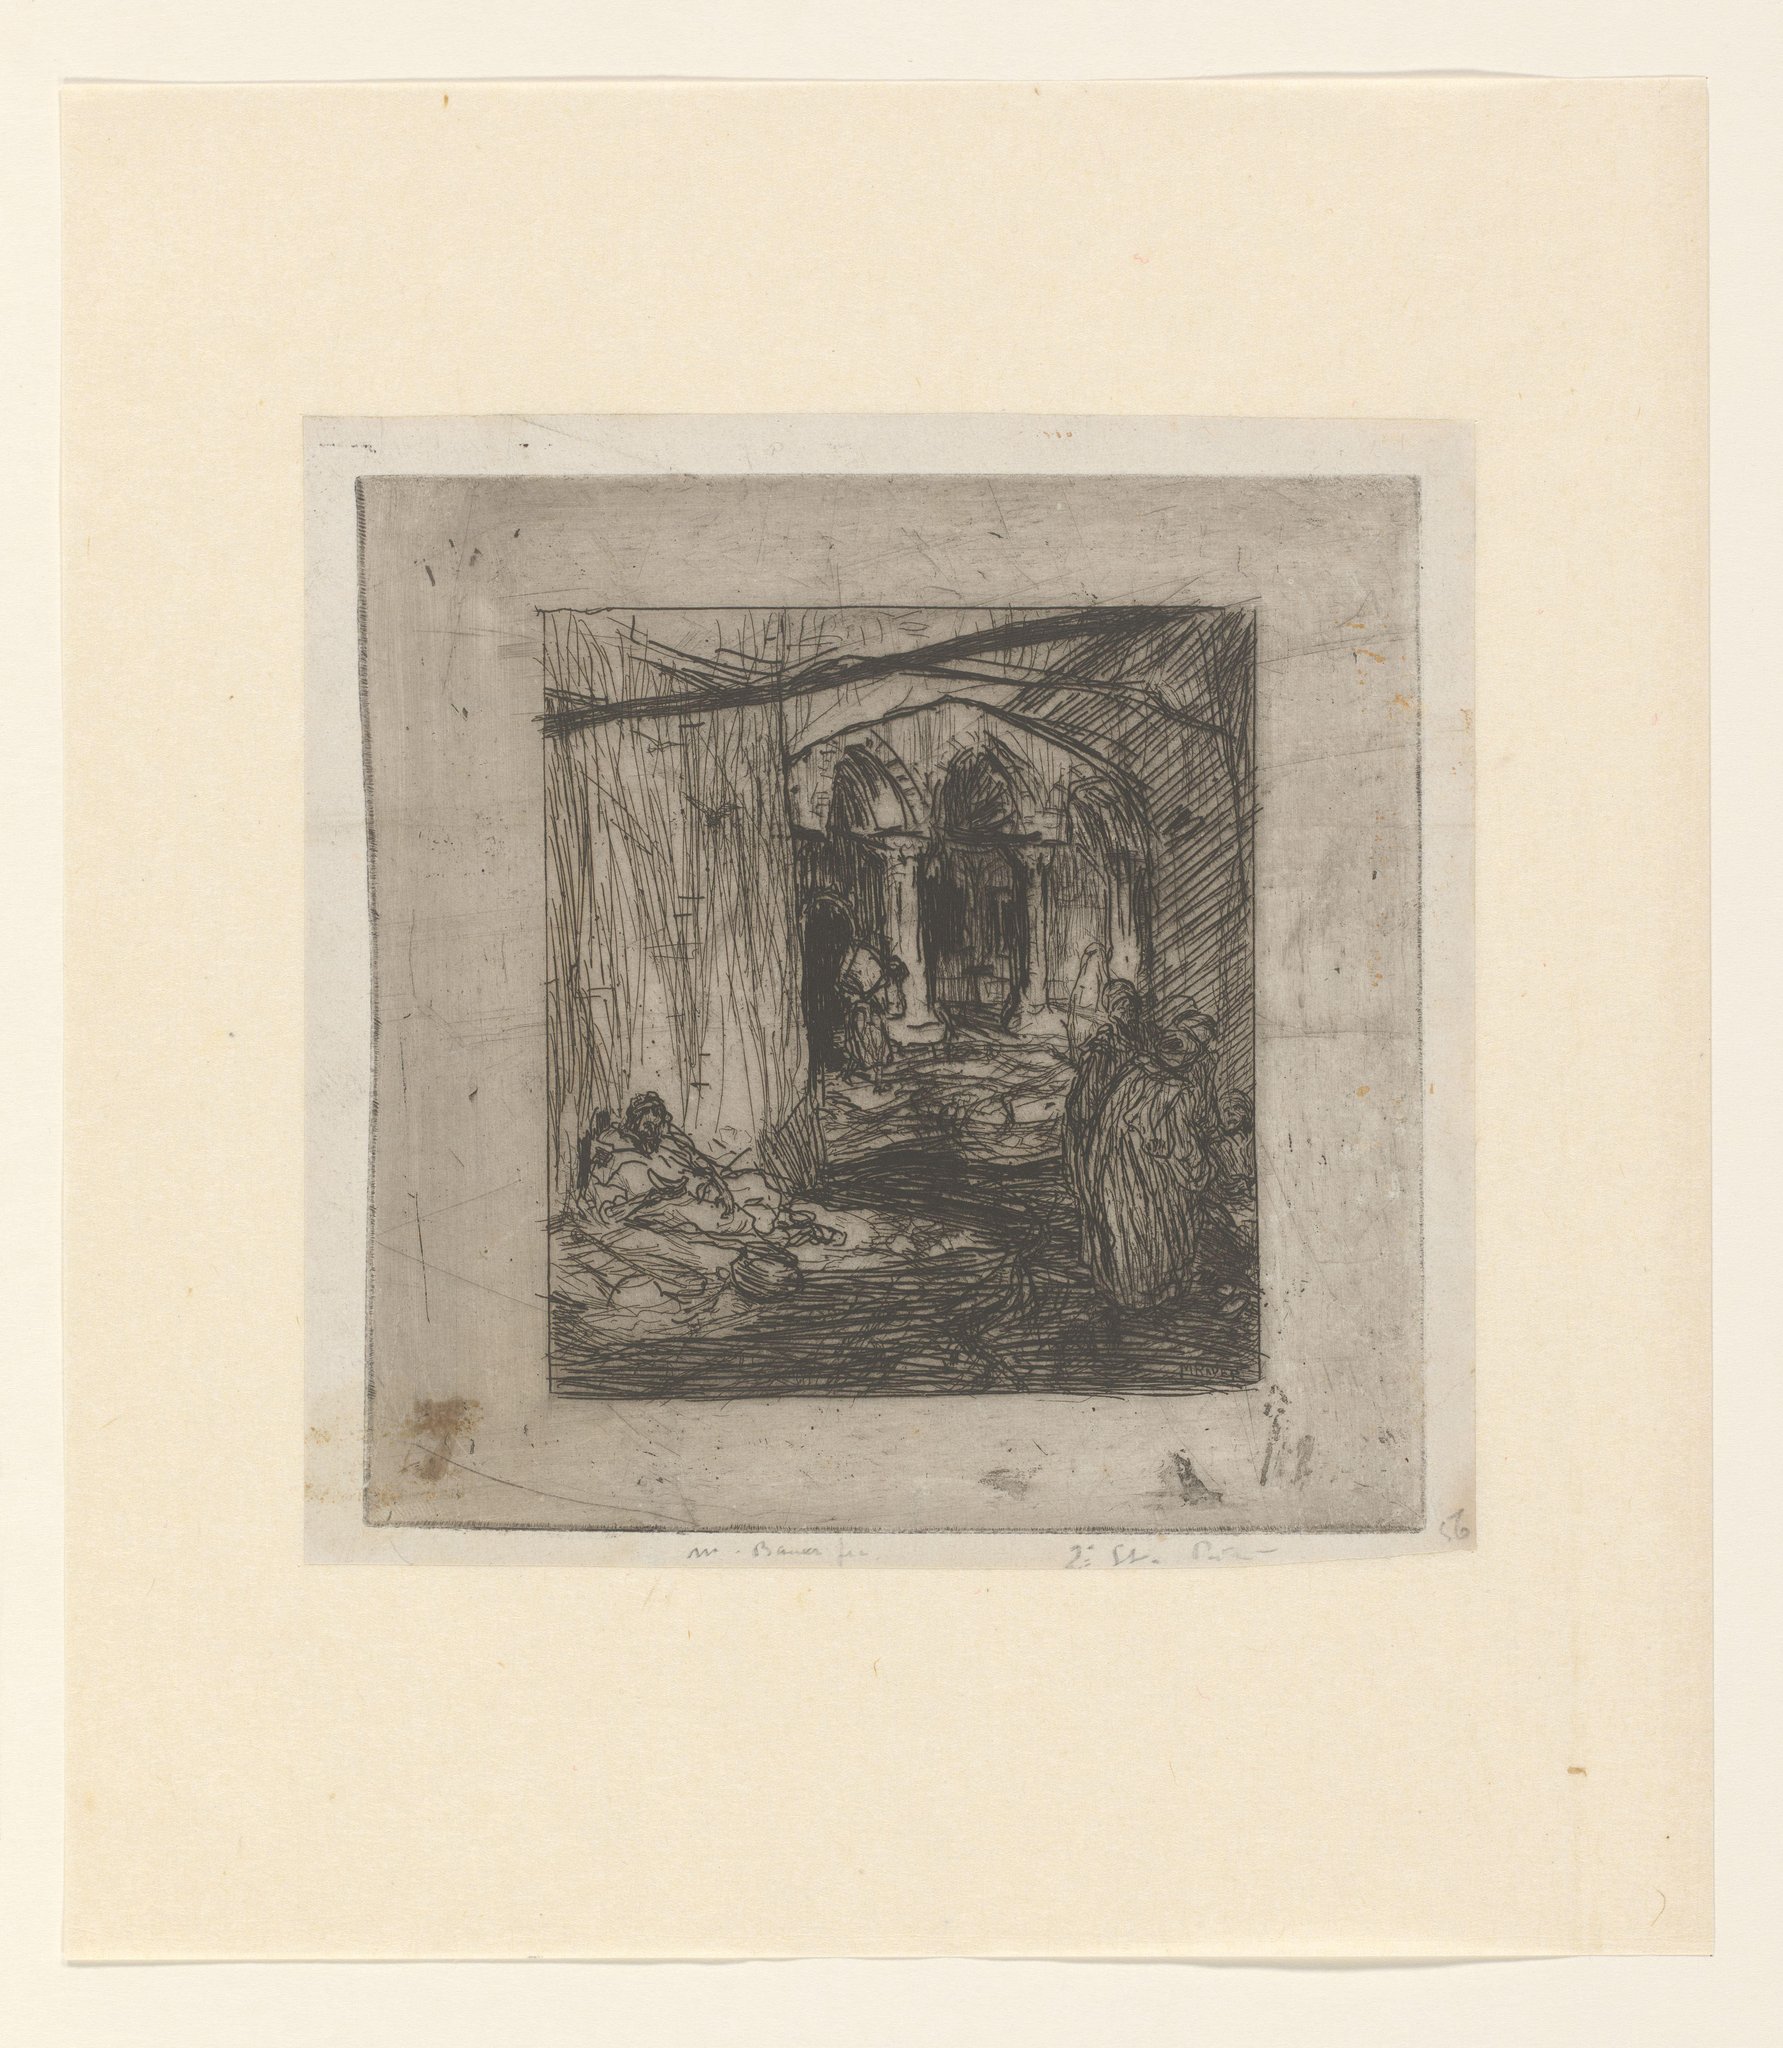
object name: print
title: Voddenrapers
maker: marius bauer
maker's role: draughtsman, print maker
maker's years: 1867-1932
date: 1888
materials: paper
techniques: etching, intaglio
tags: merchant, salesman, textile fabric, cloth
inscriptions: collector's mark: Lugt 2228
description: Figuren in oosterse kleding op een straat, waaronder een liggende man.